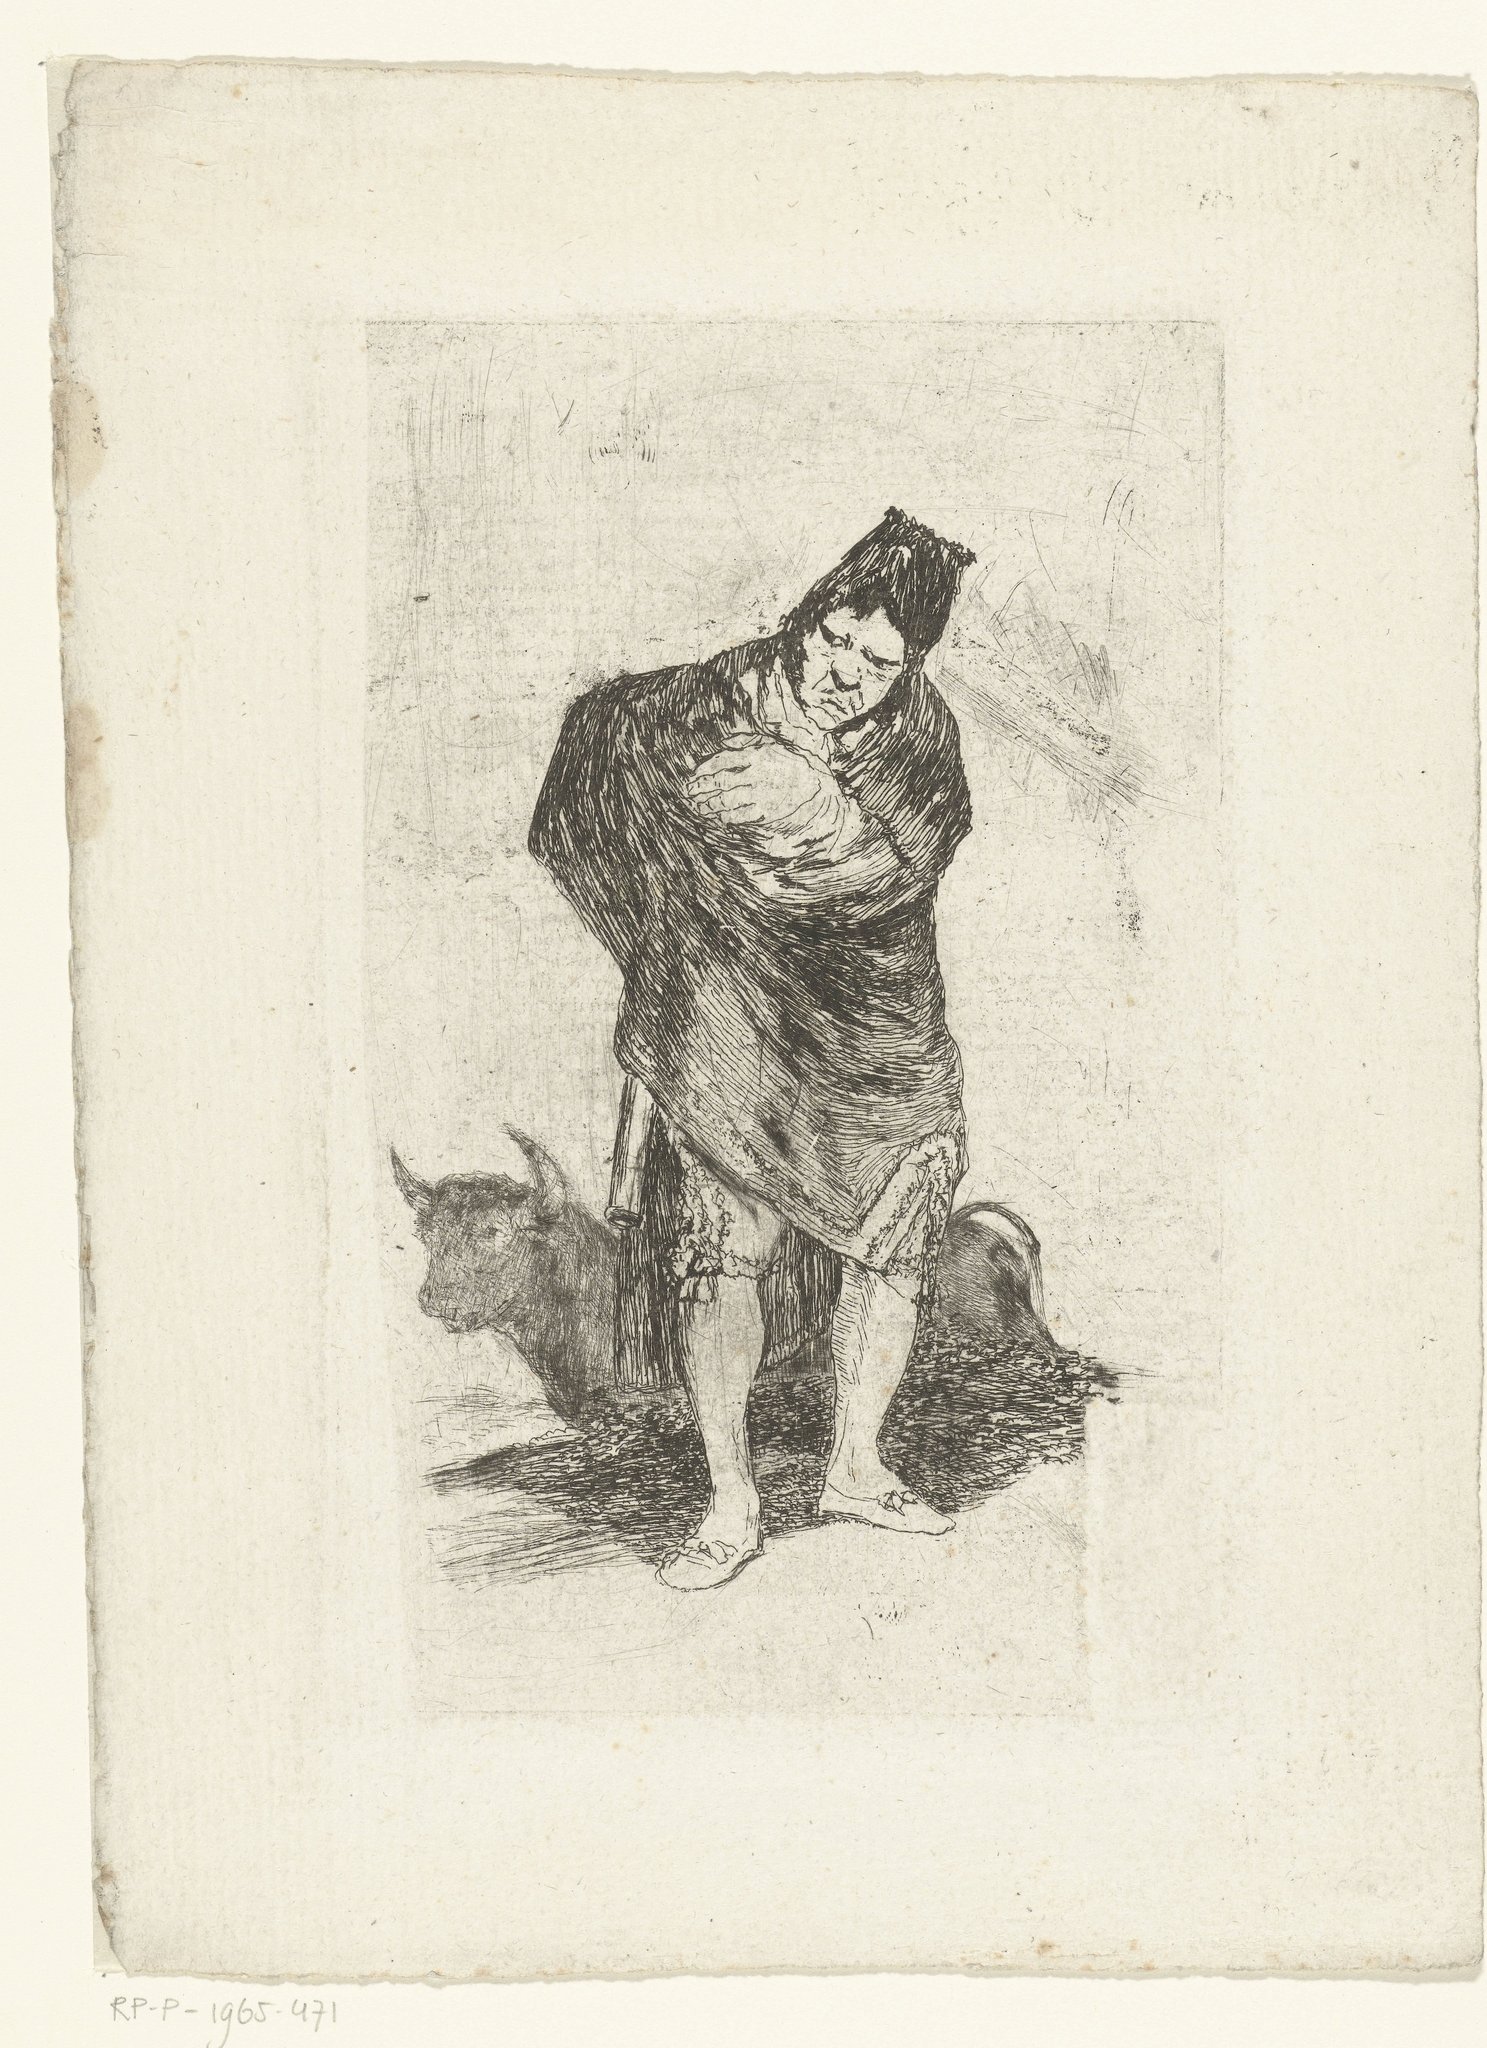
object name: print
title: El embozado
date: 1824-1828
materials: paper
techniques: drypoint, etching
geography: madrid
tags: bull, bull-fighter, toreador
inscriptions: collector's mark: Lugt 2228, collector's mark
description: Een oude stierenvechter, van voren gezien, zijn cape om zich heen geslagen. Achter hem een stier.